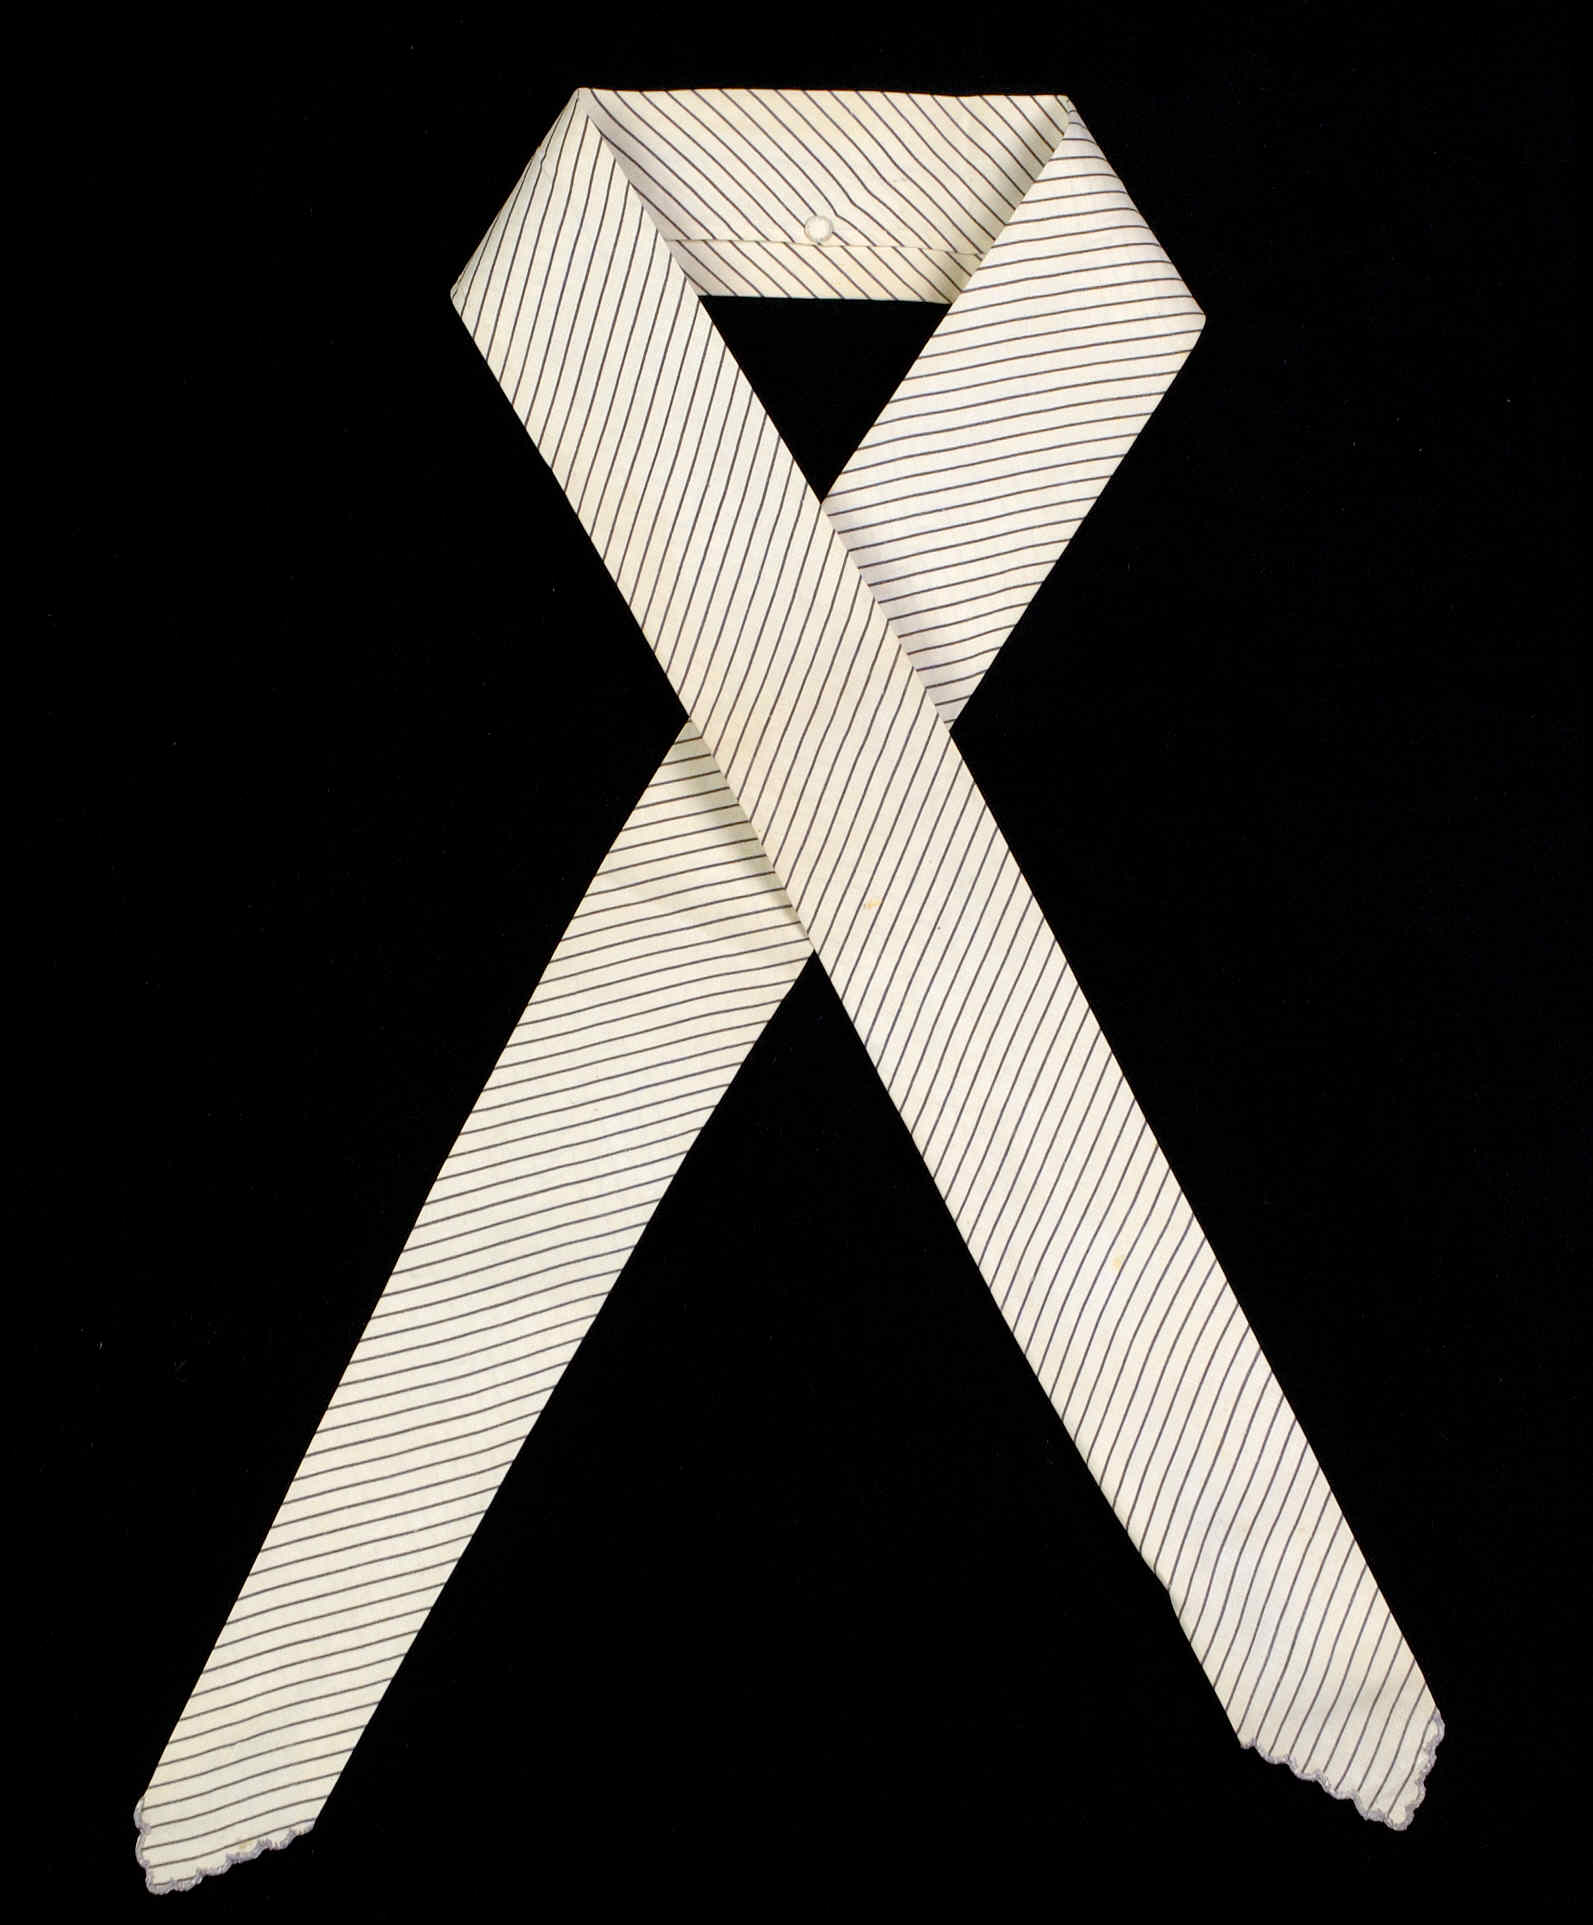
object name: cravat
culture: american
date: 1851-1875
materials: linen